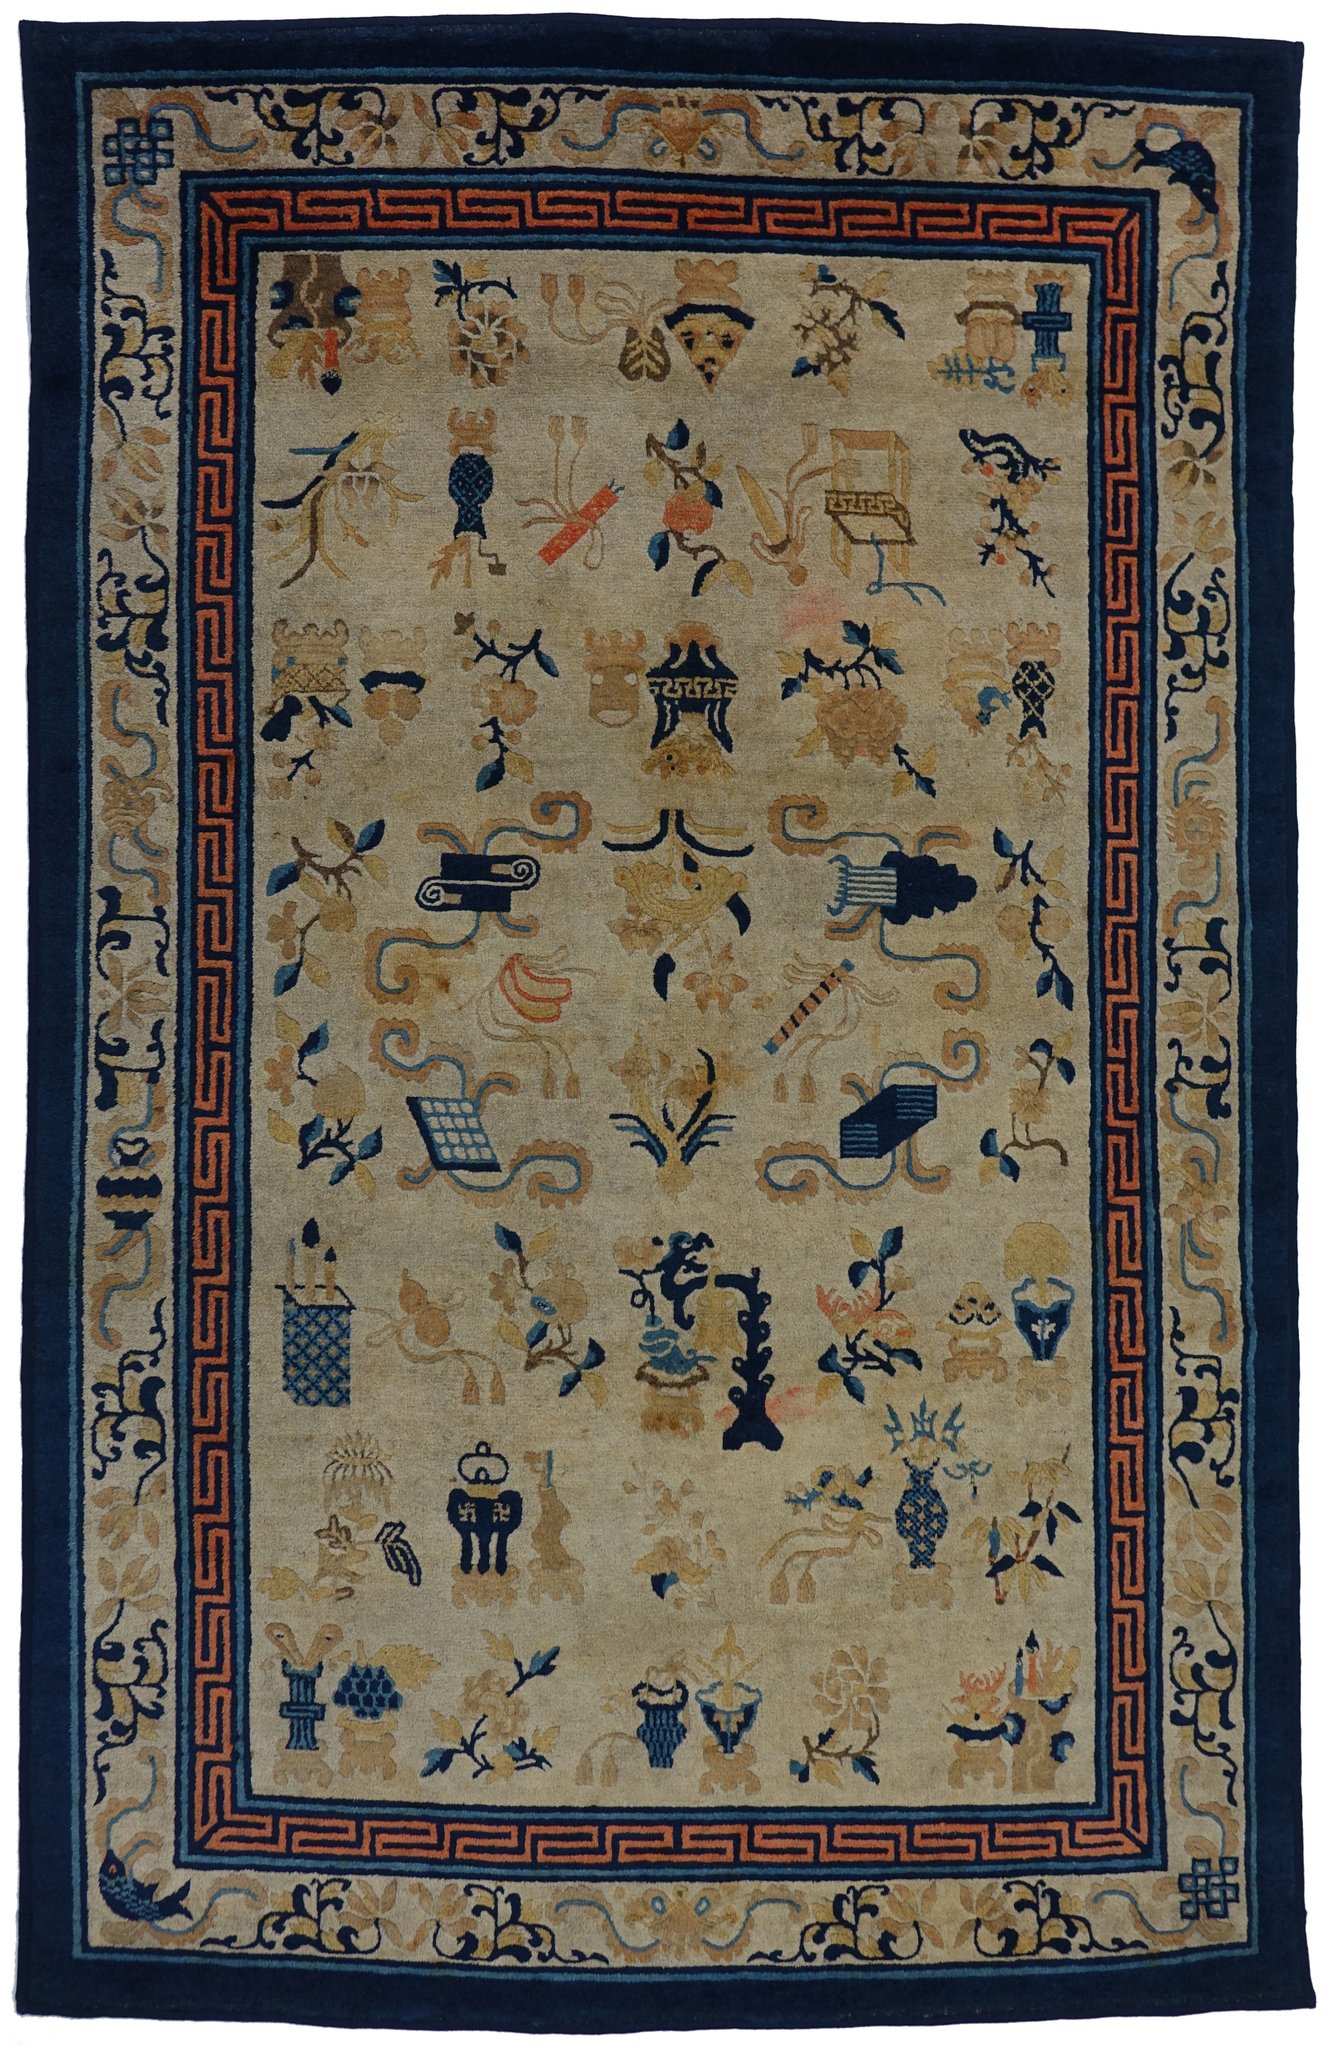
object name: rug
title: Rug with the "Hundred Antiques"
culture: chinese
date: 1801-1900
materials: cotton, wool